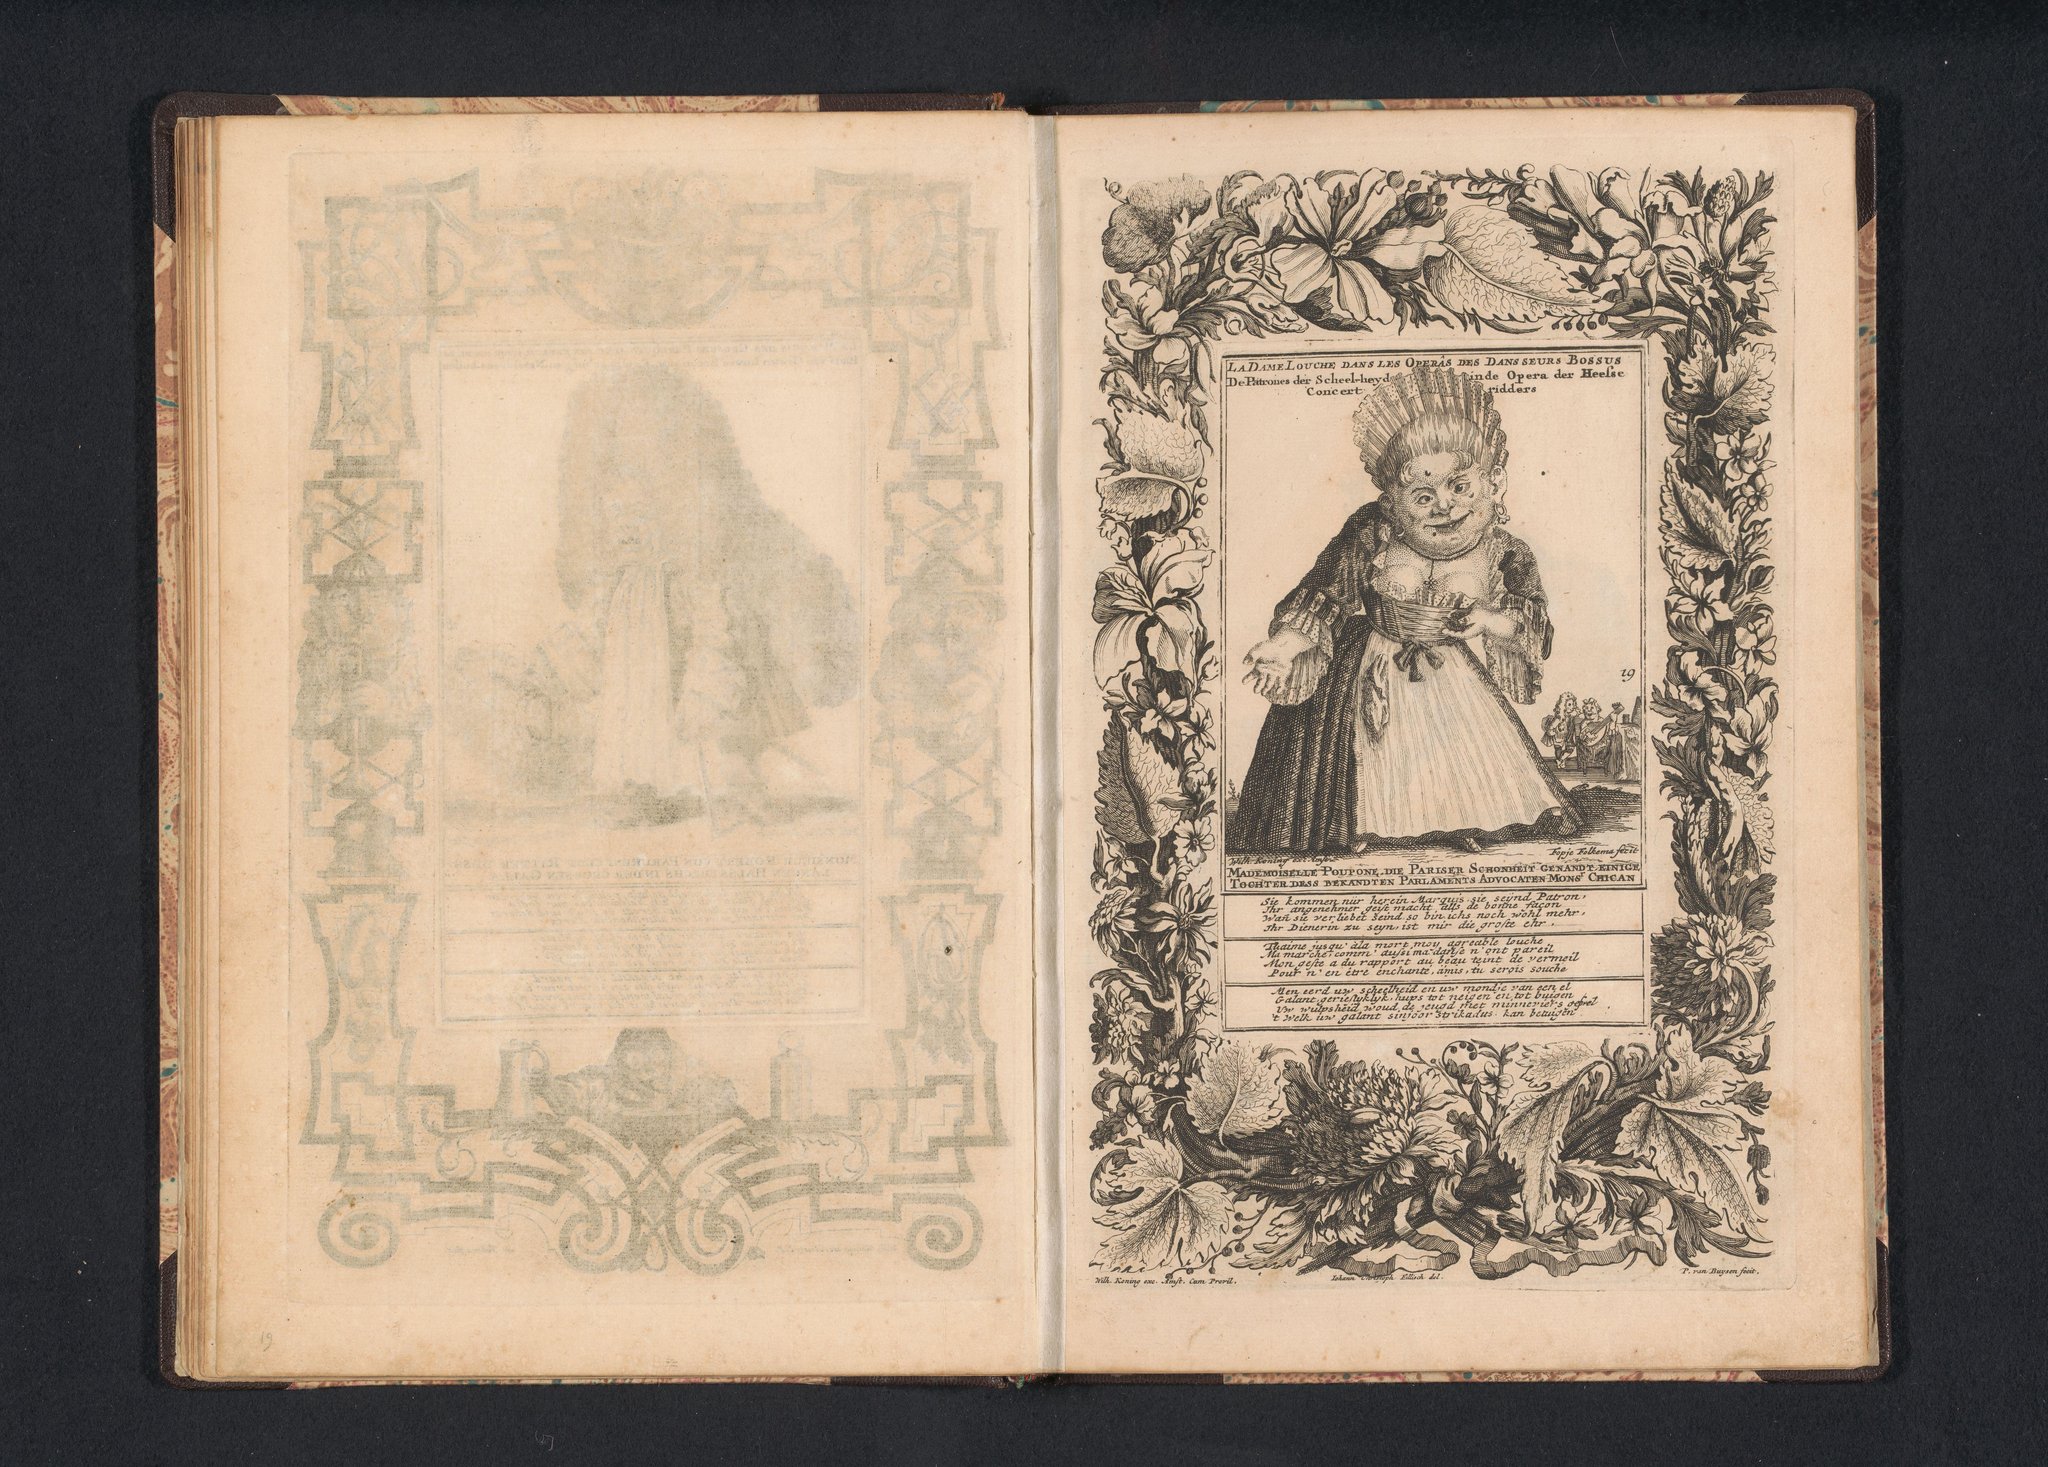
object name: caricature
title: Il Callotto resuscitato oder Neü eingerichtes Zwerchen Cabinet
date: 1716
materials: paper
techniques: etching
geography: amsterdam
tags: caricatures (human types), little people, opera-singer (female)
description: De kleine mens Patrones der Scheel-heyd in de Opera der Heese Concertridders, als Parijse schone. In het onderschrift verzen in het Duits, Frans en Nederlands. Afdruk binnen een decoratieve omlijsting gedrukt van een aparte plaat met bloemen en bladeren. Genummerd rechts midden: 19. Onderdeel van de Nederlandse gebonden uitgave uit 1716 van een serie karikaturen van kleine mensen, bekend als Het Dwergentooneel, gekopieerd naar een ouder Duits voorbeeld.